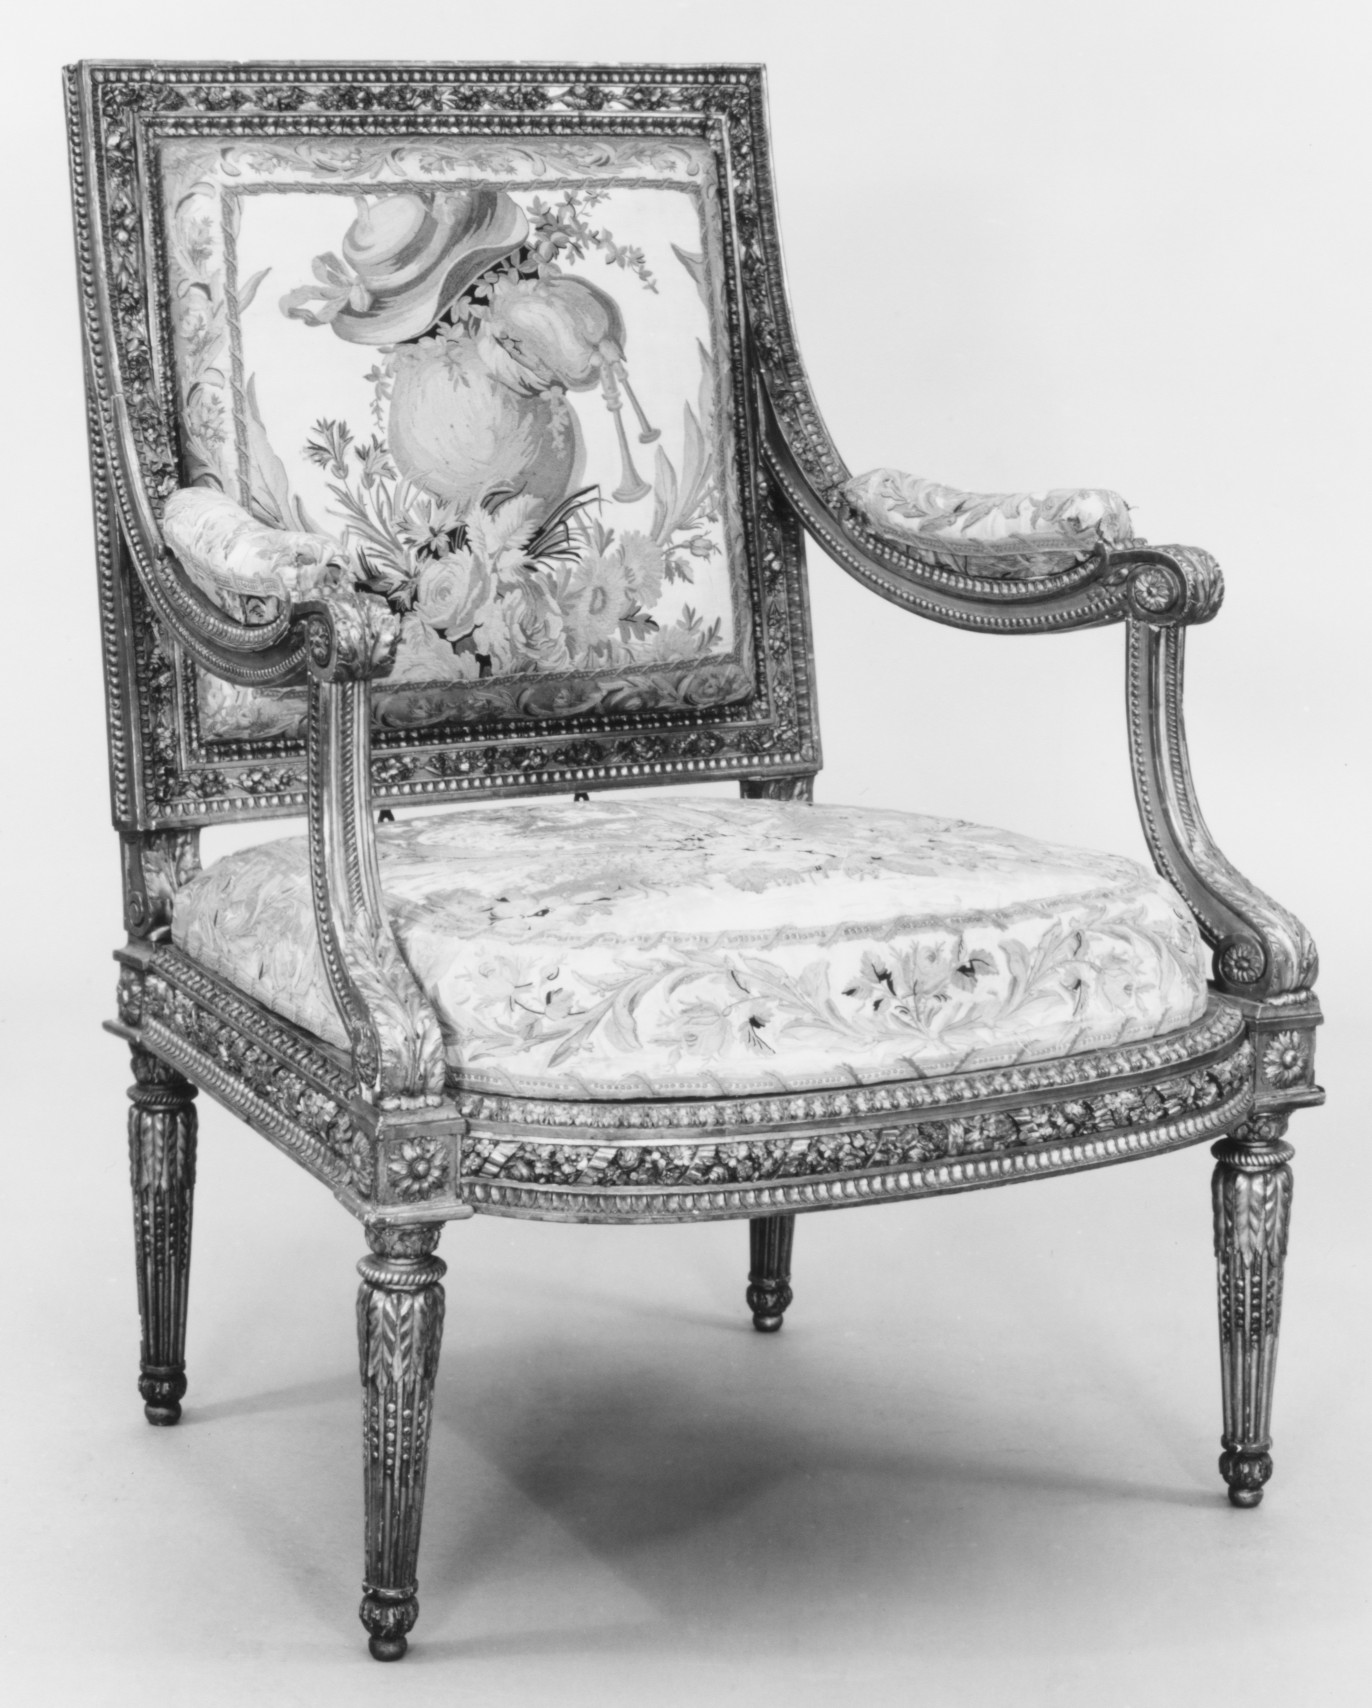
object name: armchair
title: Armchair (part of a set)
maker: georges jacob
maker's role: maker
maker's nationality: french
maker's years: 1739-1814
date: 1785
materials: silk, wood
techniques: carving, embroidery, gilding